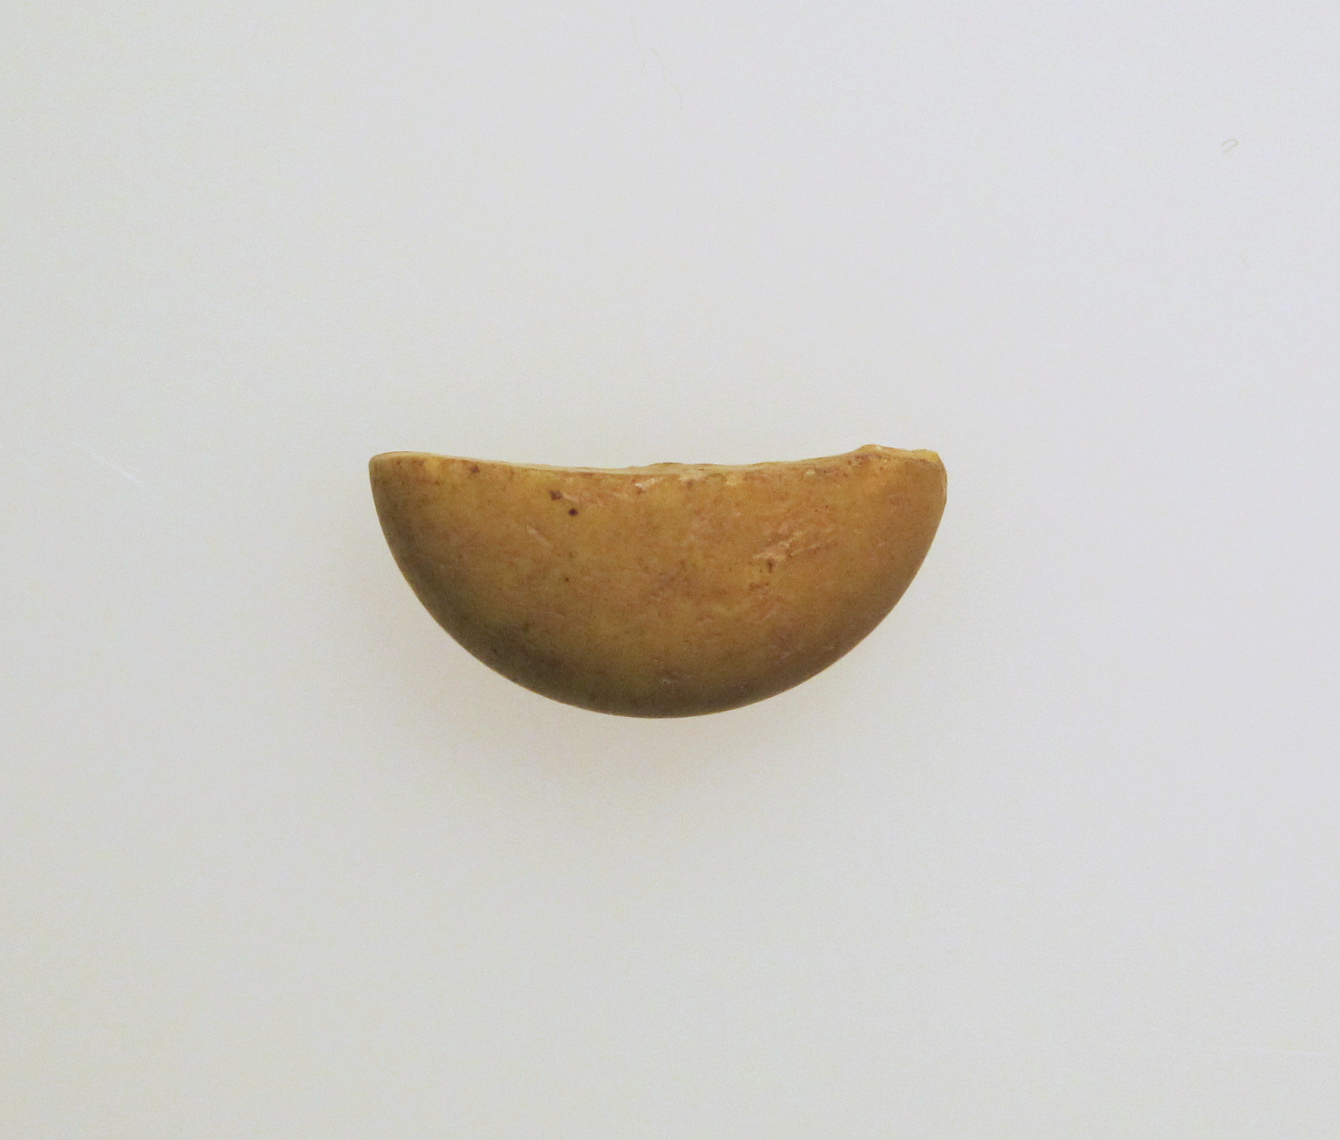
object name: pinhead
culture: roman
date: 100 BCE-500 CE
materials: glass